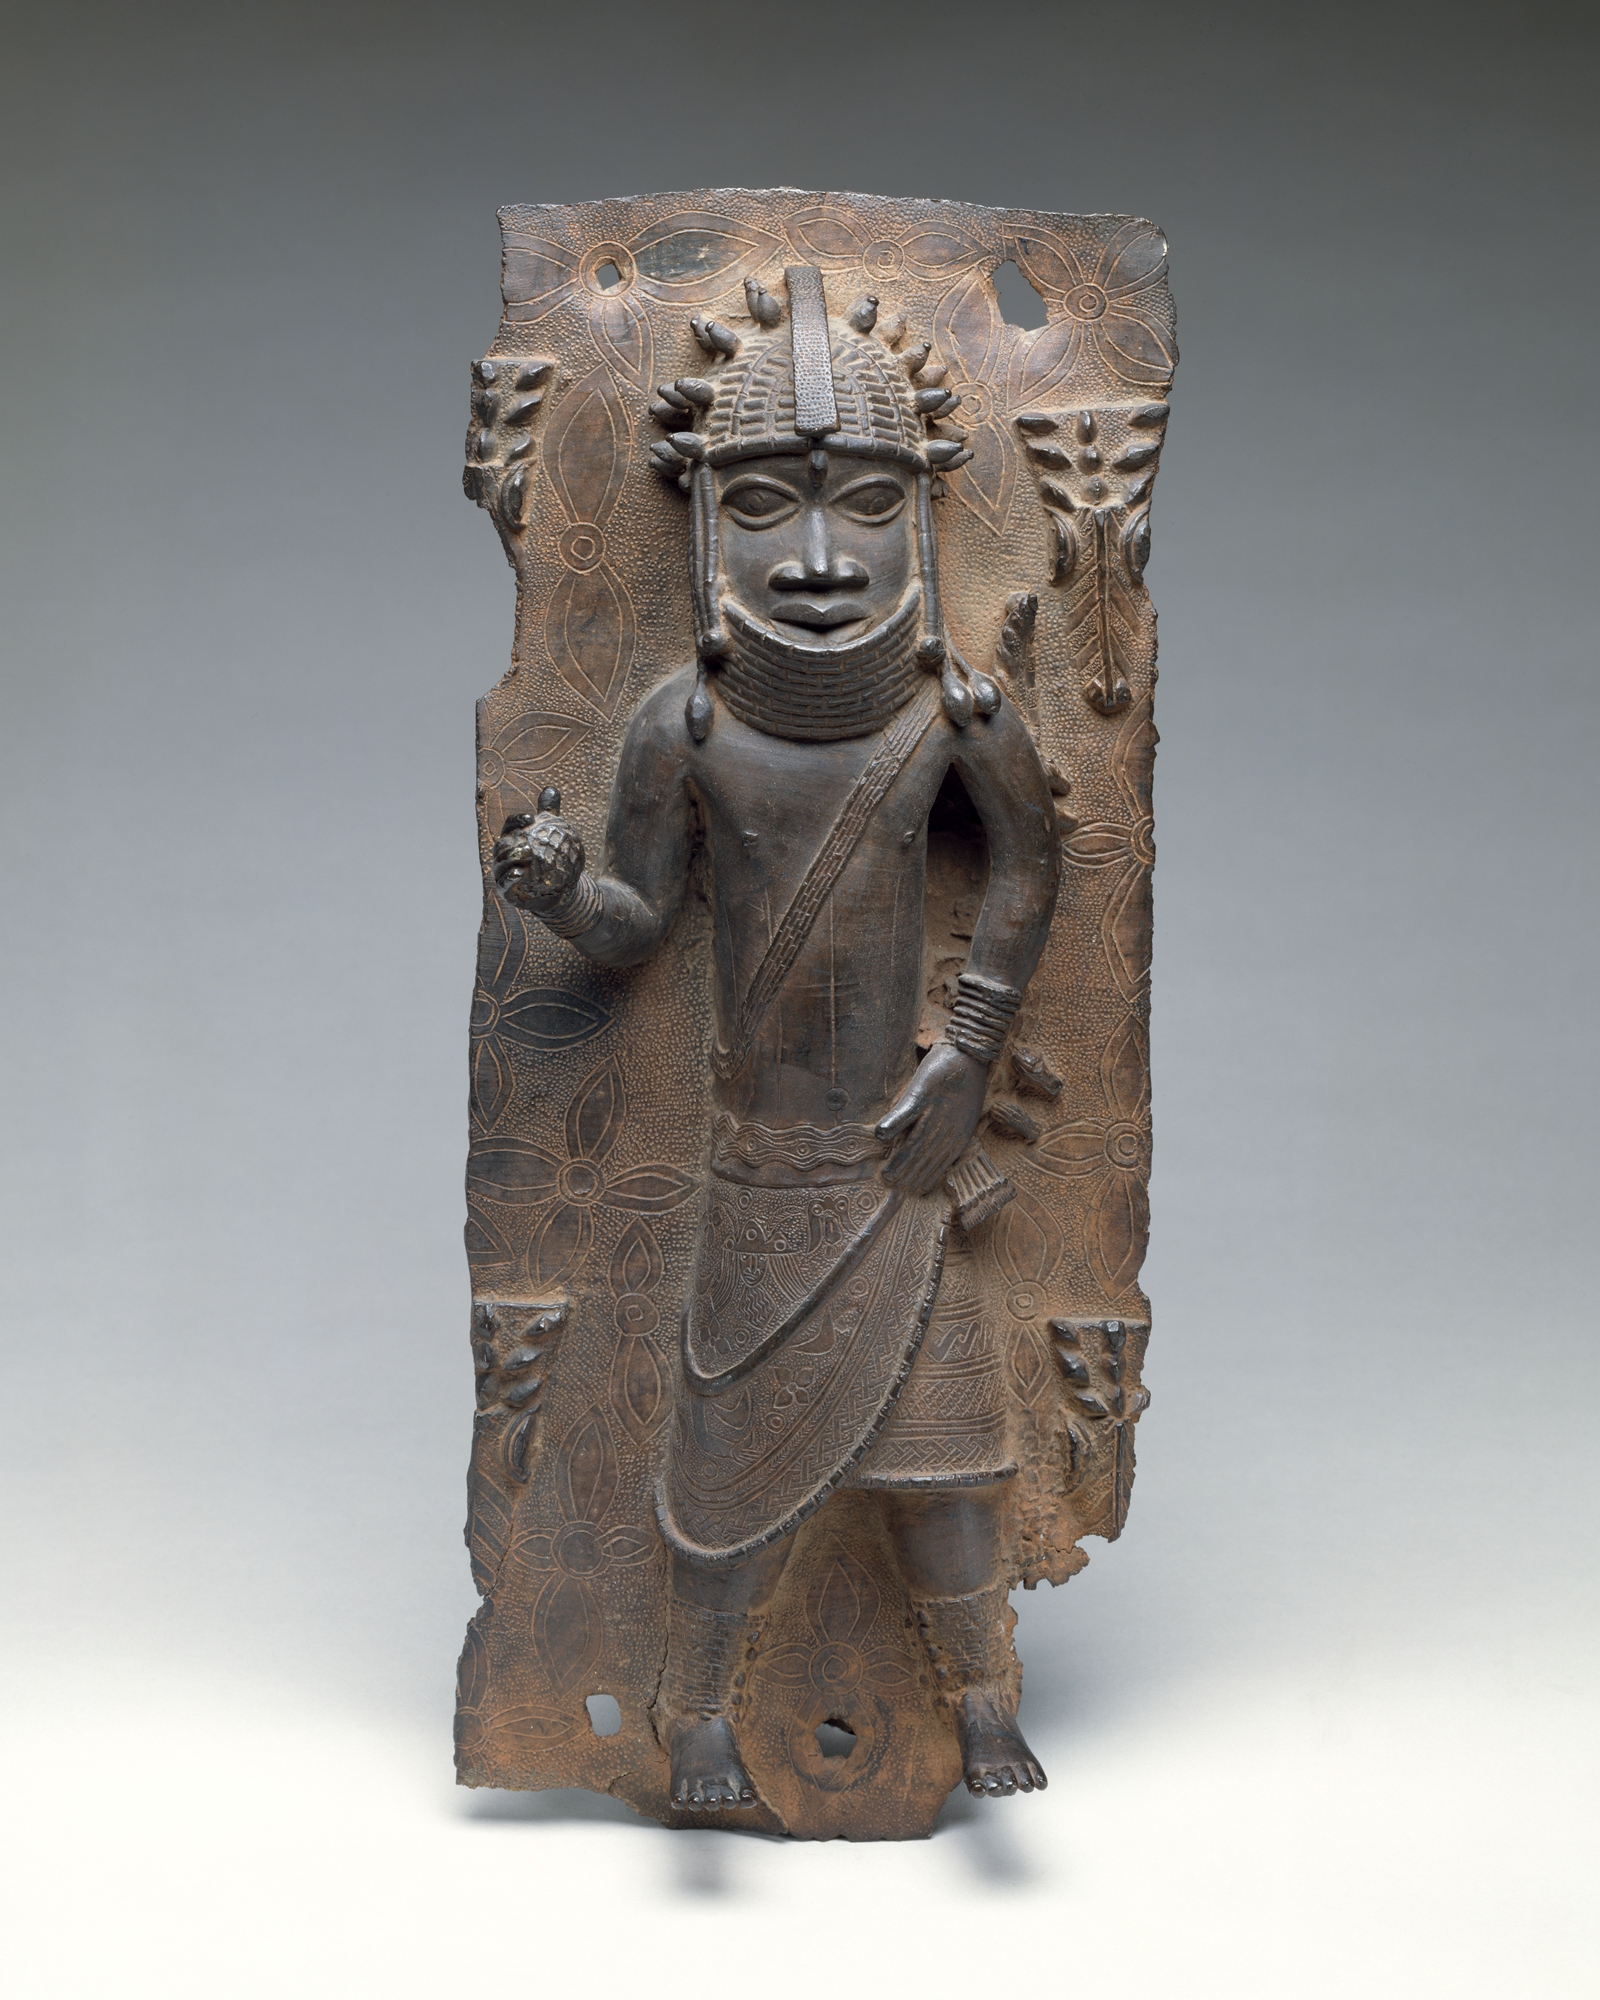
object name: plaque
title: Plaque with Court Official Holding a Protective Rattle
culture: edo period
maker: ìgùn ẹ́rọ̀nwwọ̀n (brass-casting guild) artists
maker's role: artist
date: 1540-1570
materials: brass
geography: nigeria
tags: musical instruments,vegetables,men